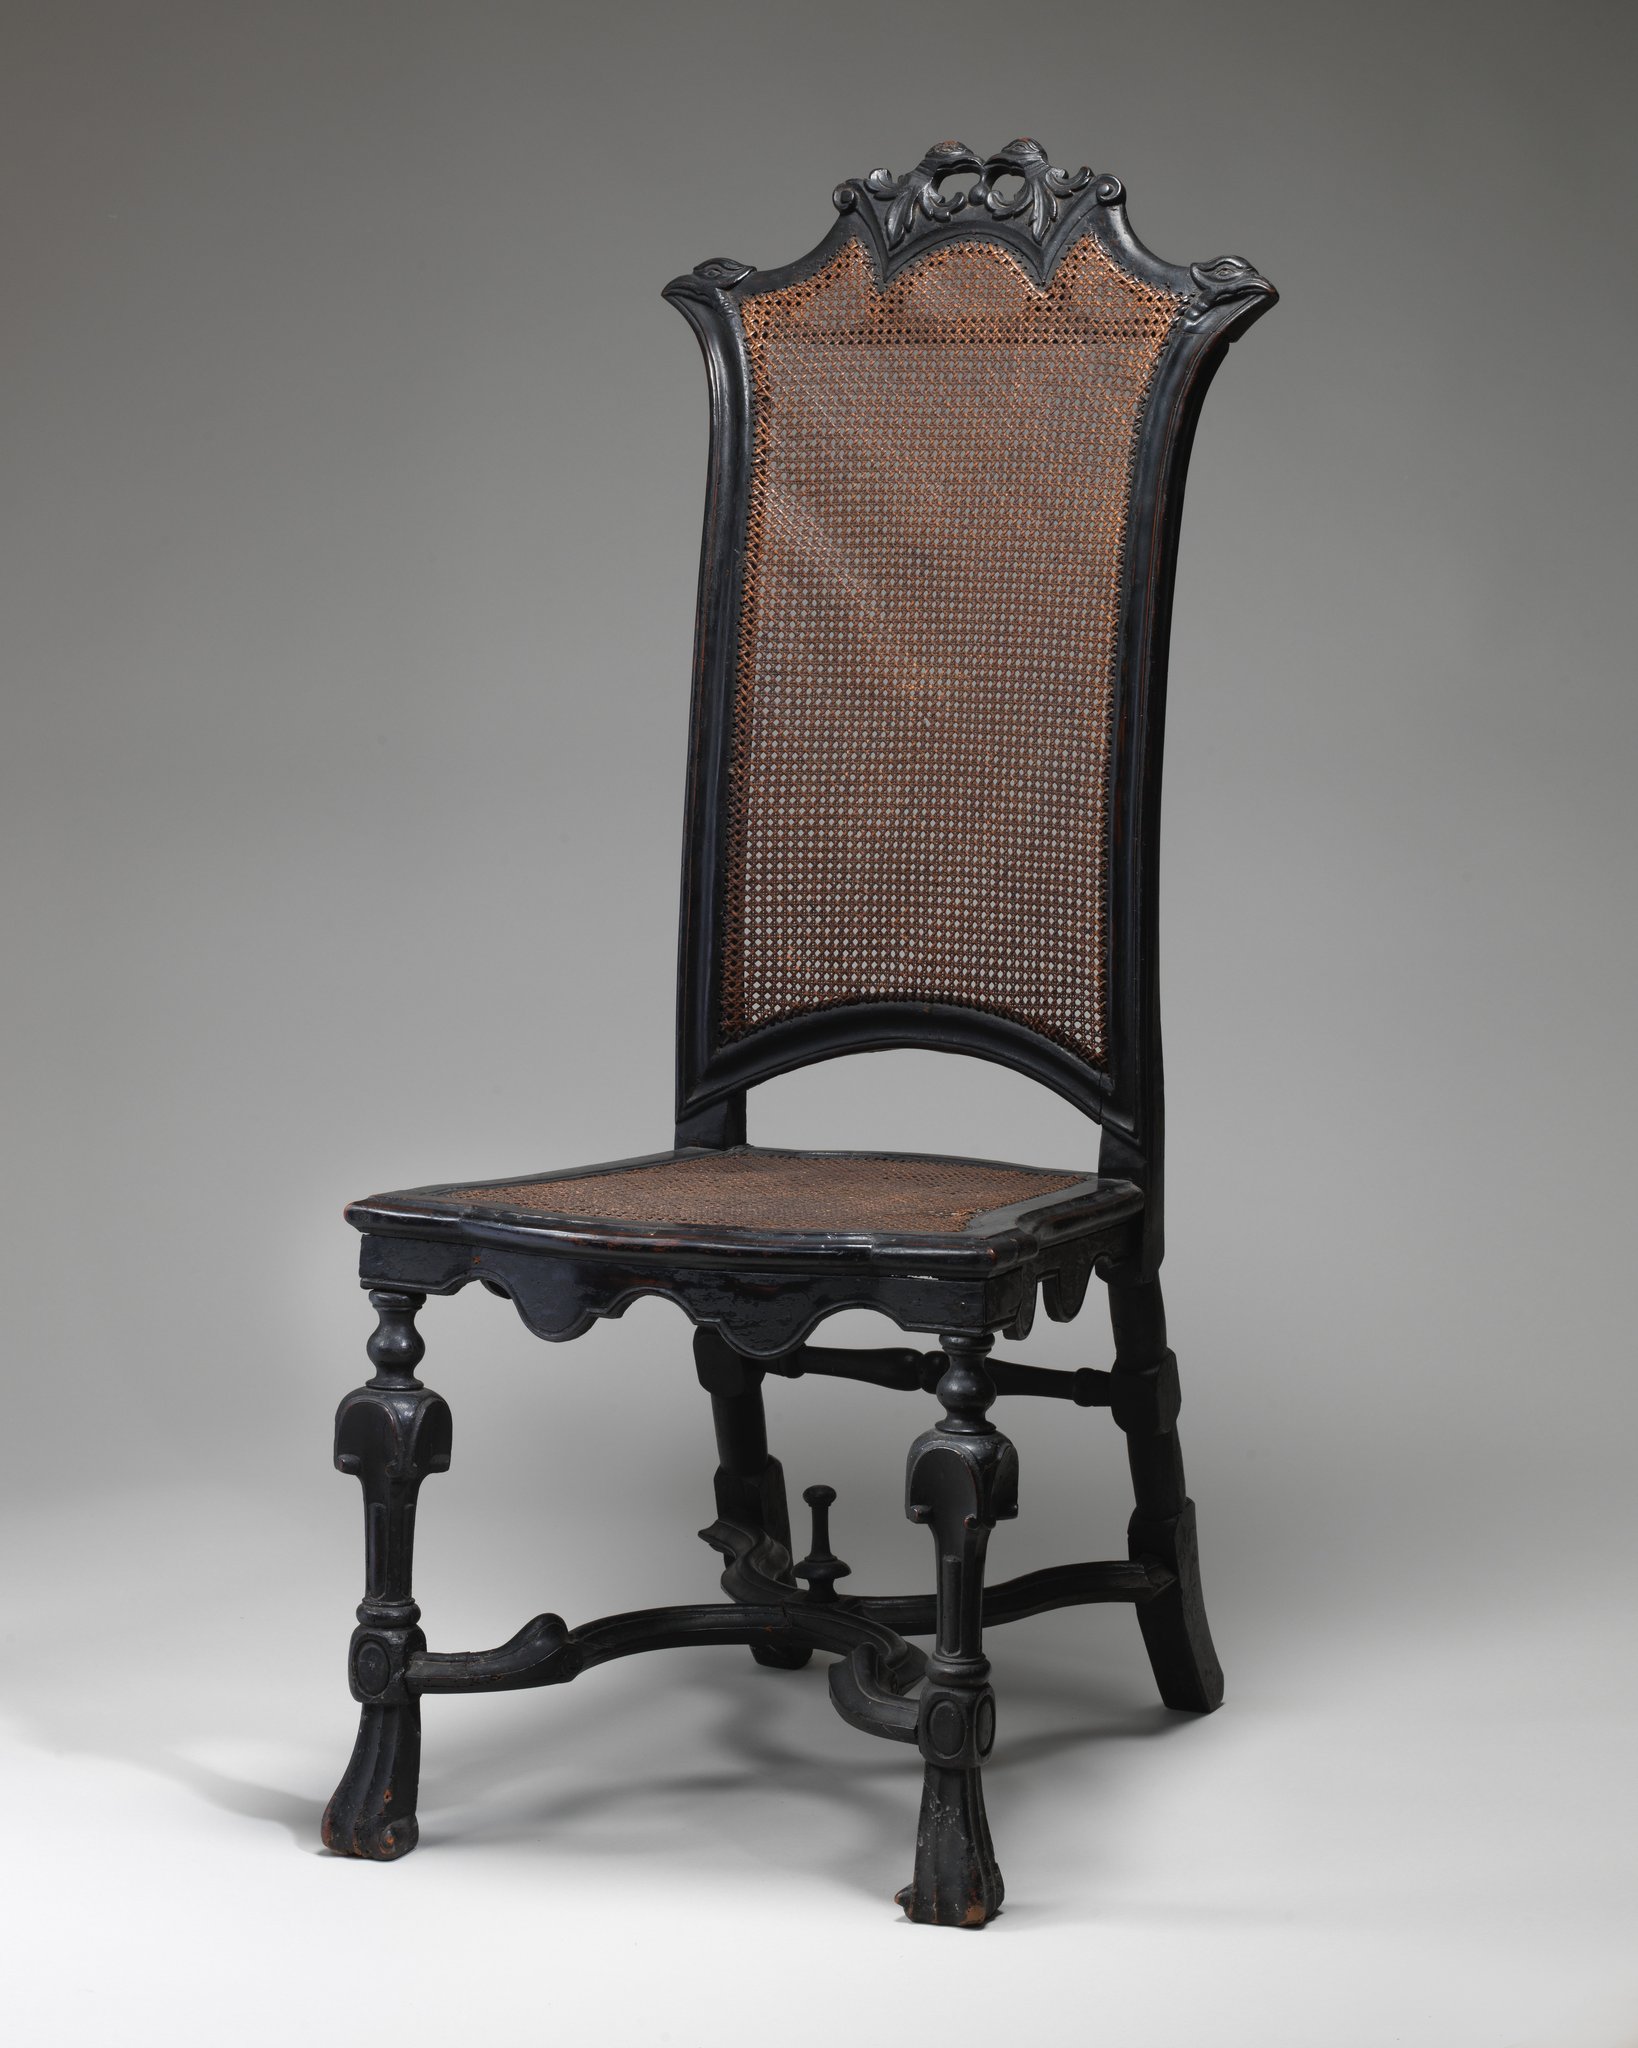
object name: side chair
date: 1667-1700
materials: wood, rattan